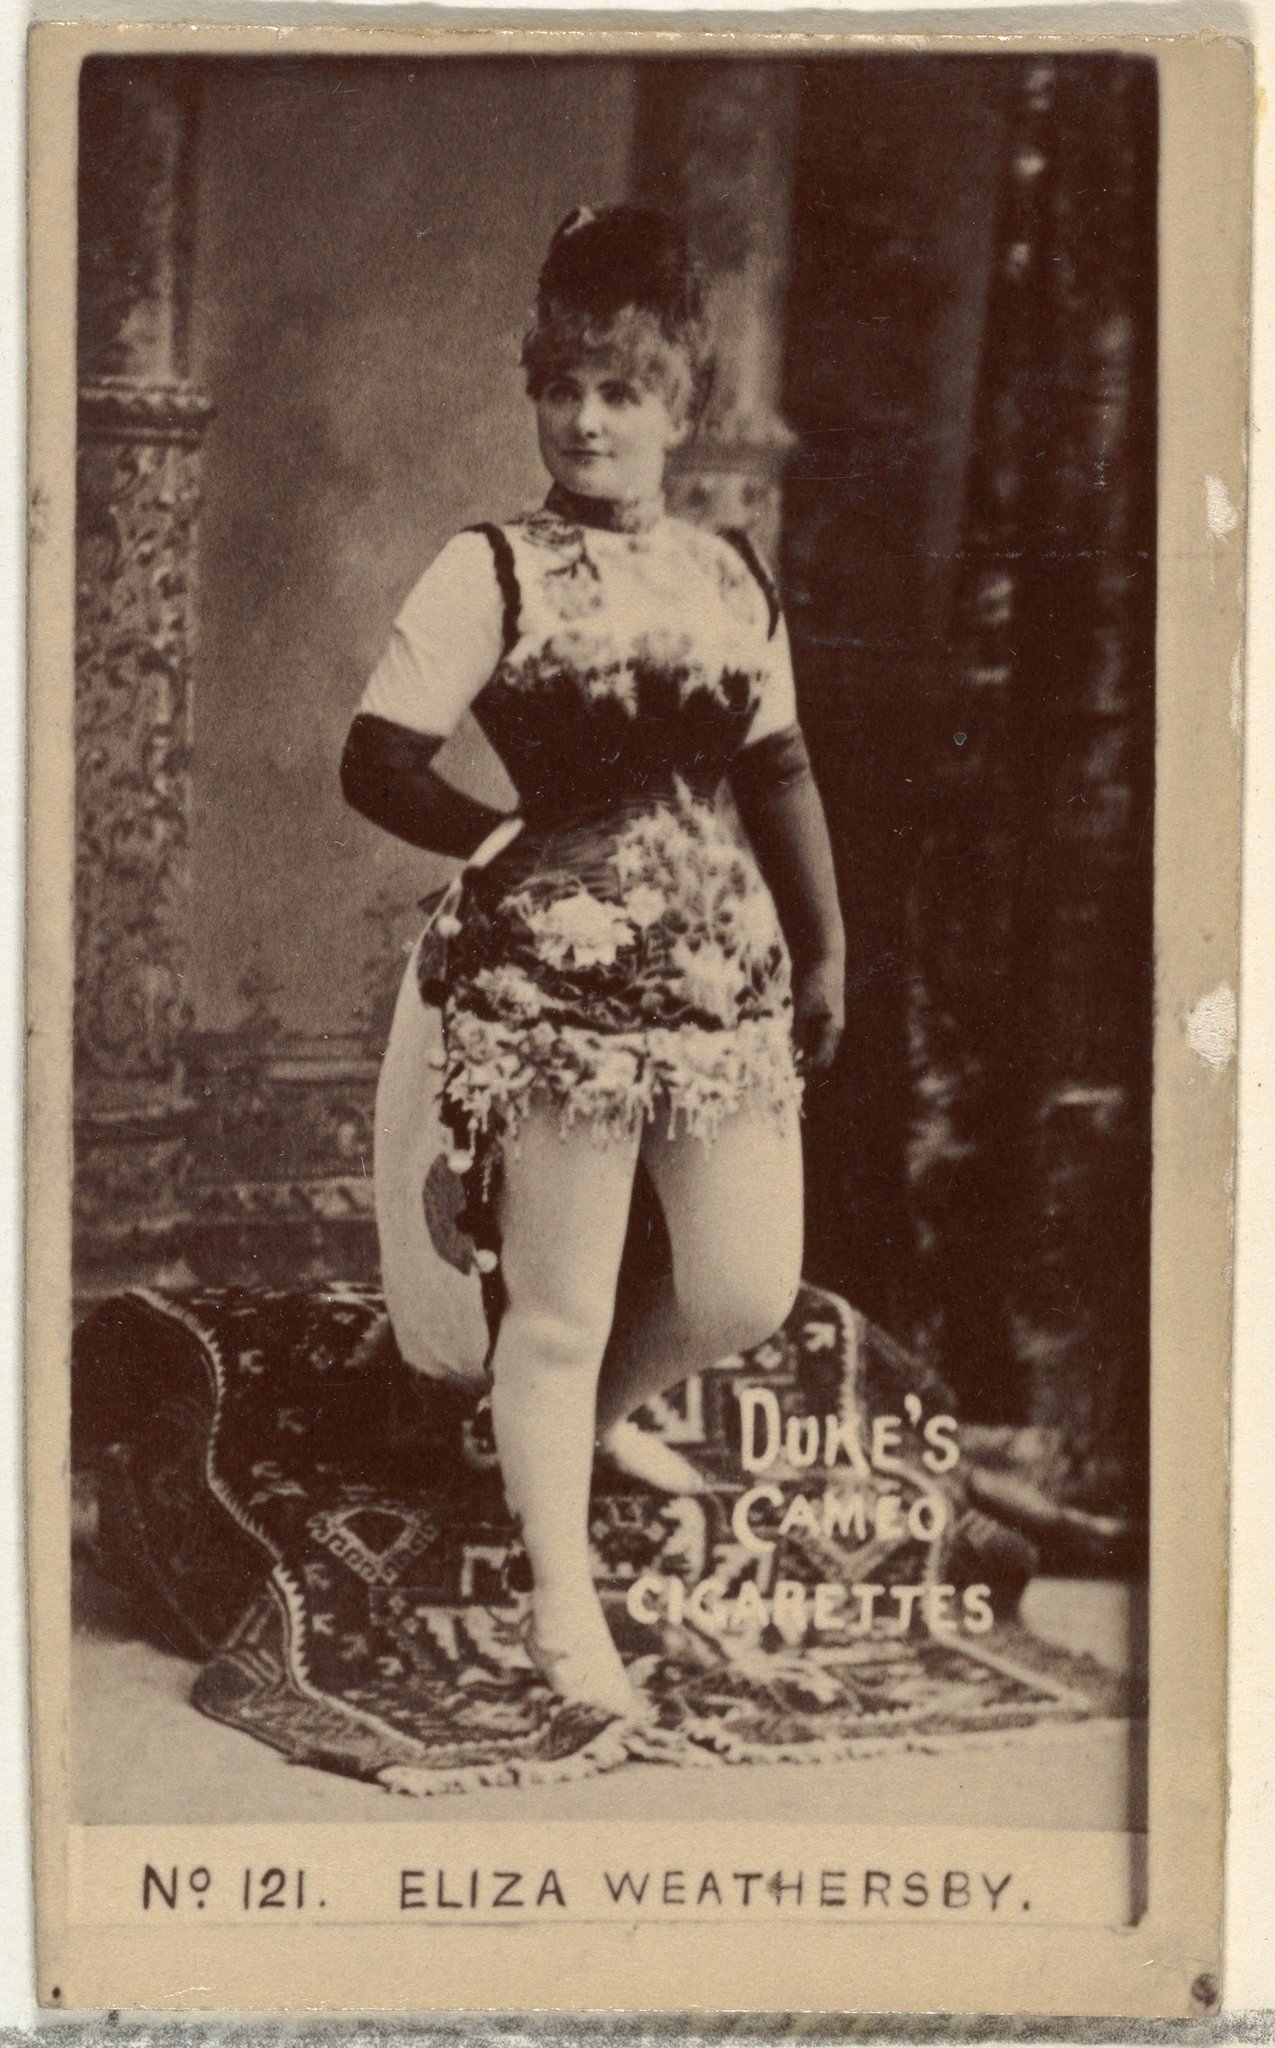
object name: photograph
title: Card Number 121, Eliza Weathersby, from the Actors and Actresses series (N145-4) issued by Duke Sons & Co. to promote Cameo Cigarettes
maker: w. duke, sons & co.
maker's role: publisher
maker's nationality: american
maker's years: 1870-1920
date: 1880-1889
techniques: albumen silver print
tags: portraits,women,actresses